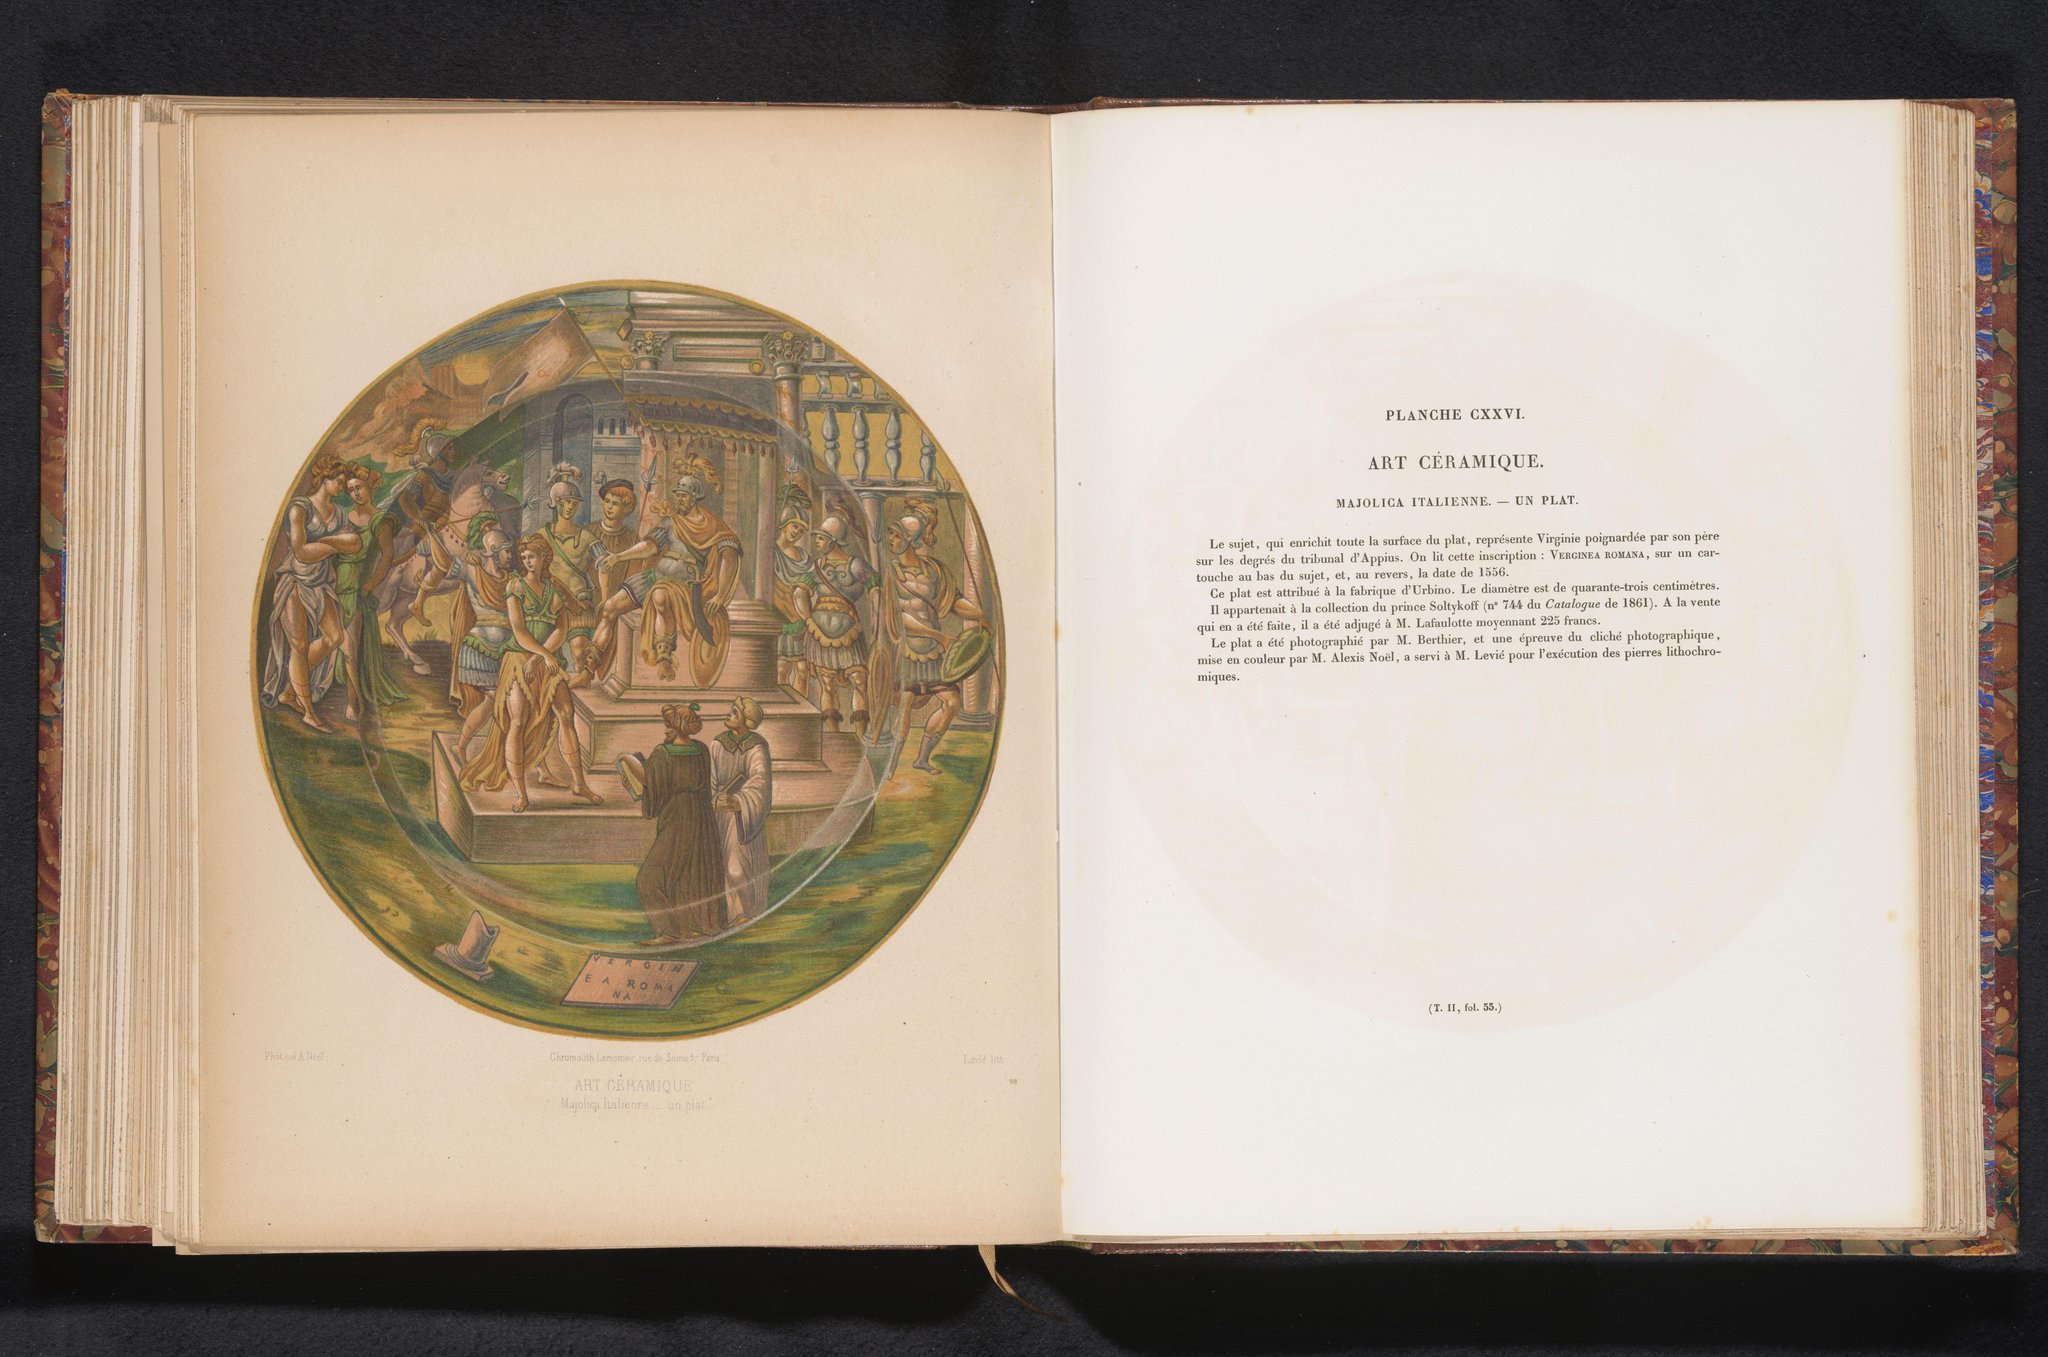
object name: page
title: Majolica Italienne, un plat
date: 1859-1864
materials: paper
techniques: chromolithography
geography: paris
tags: (story of) appius claudius caecus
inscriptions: name: ‘Phot. col. A. Noël,./ Levié lith’